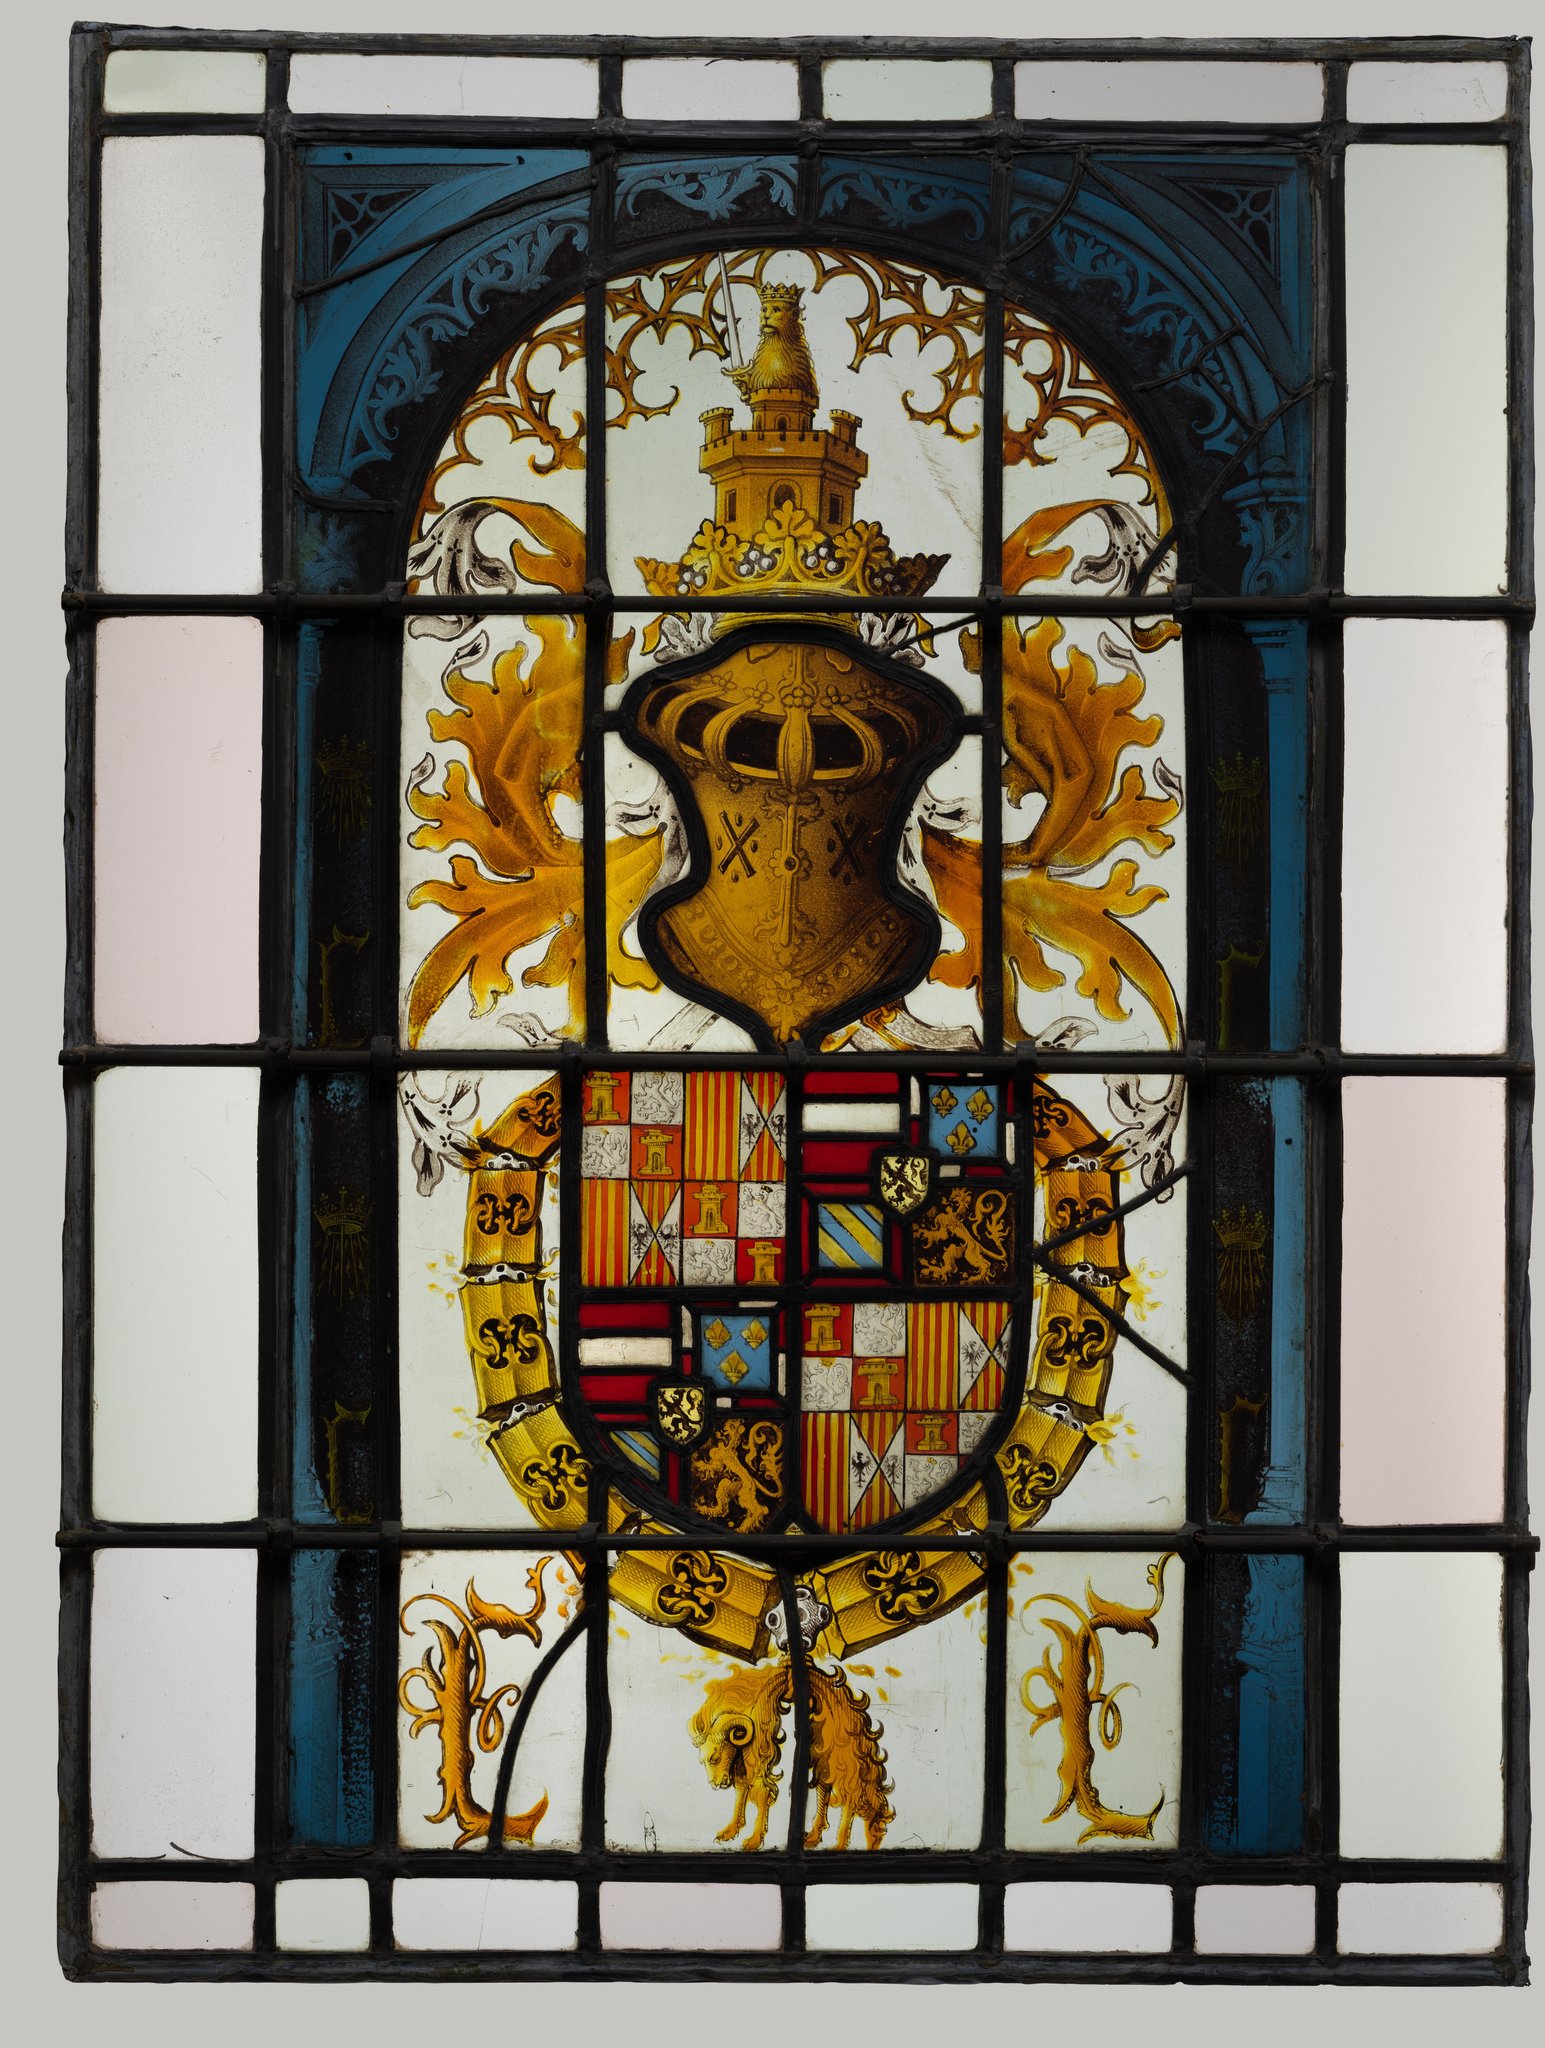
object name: panel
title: Heraldic Panel with Arms of the House of Hapsburg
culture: south netherlandish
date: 1504-1506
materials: glass, metal, paint, pigment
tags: coat of arms